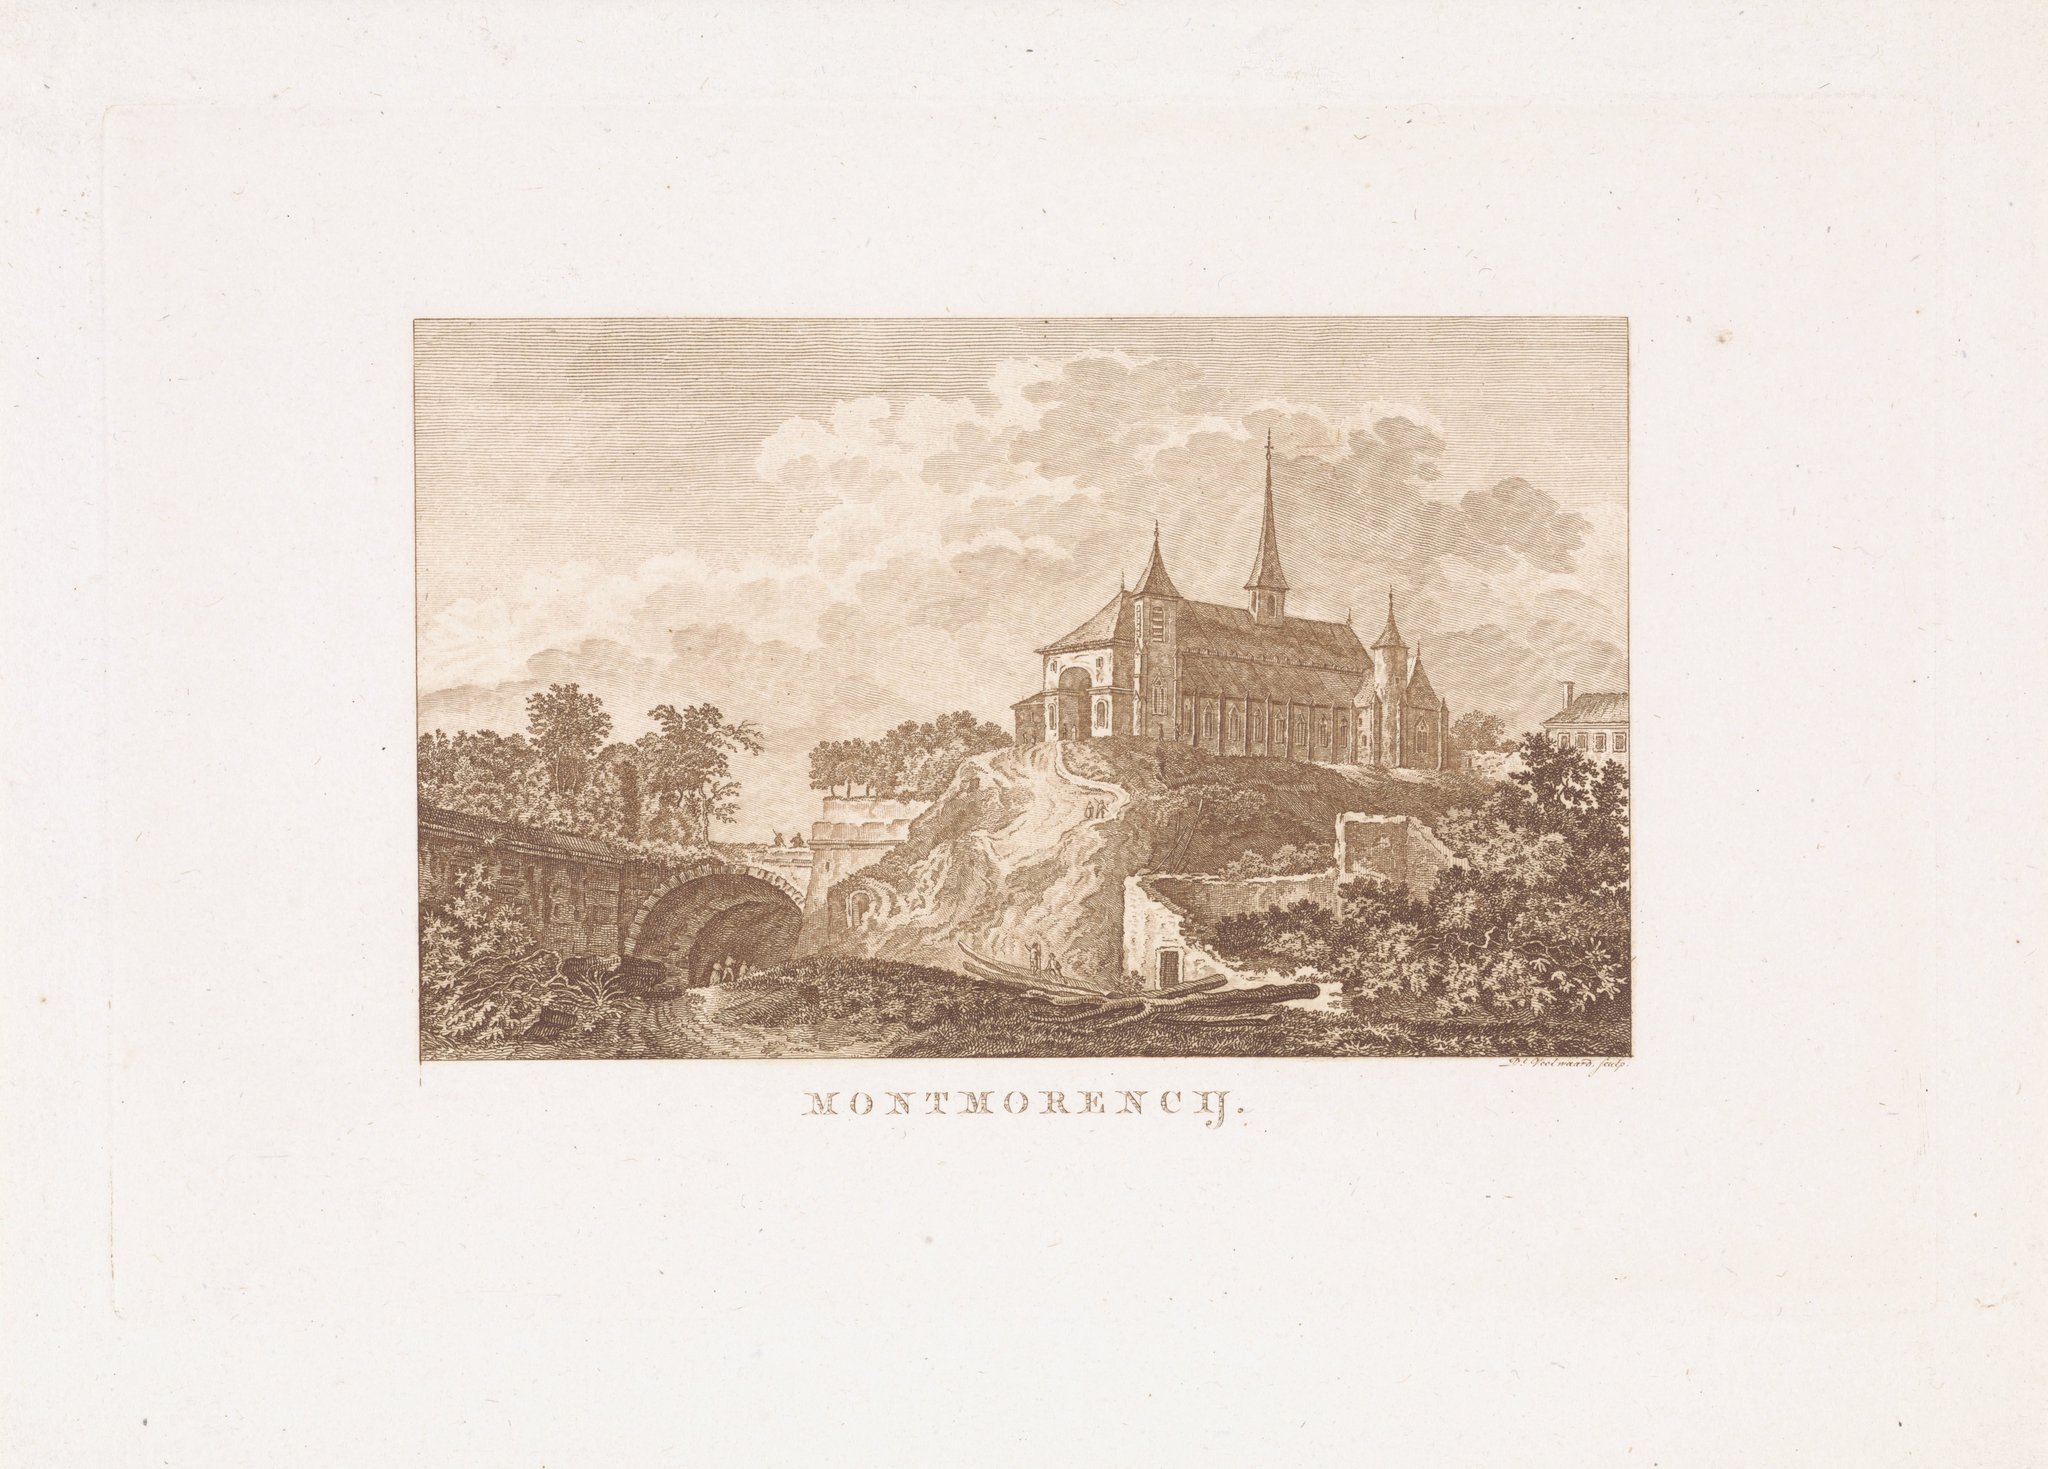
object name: print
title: Gezicht op de kerk van Montmorency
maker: daniël veelwaard (i)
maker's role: print maker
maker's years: 1766-1851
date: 1776-1851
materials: paper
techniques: etching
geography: amsterdam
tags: landscape with bridge, viaduct or aqueduct, church (exterior)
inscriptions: collector's mark: Lugt 2228